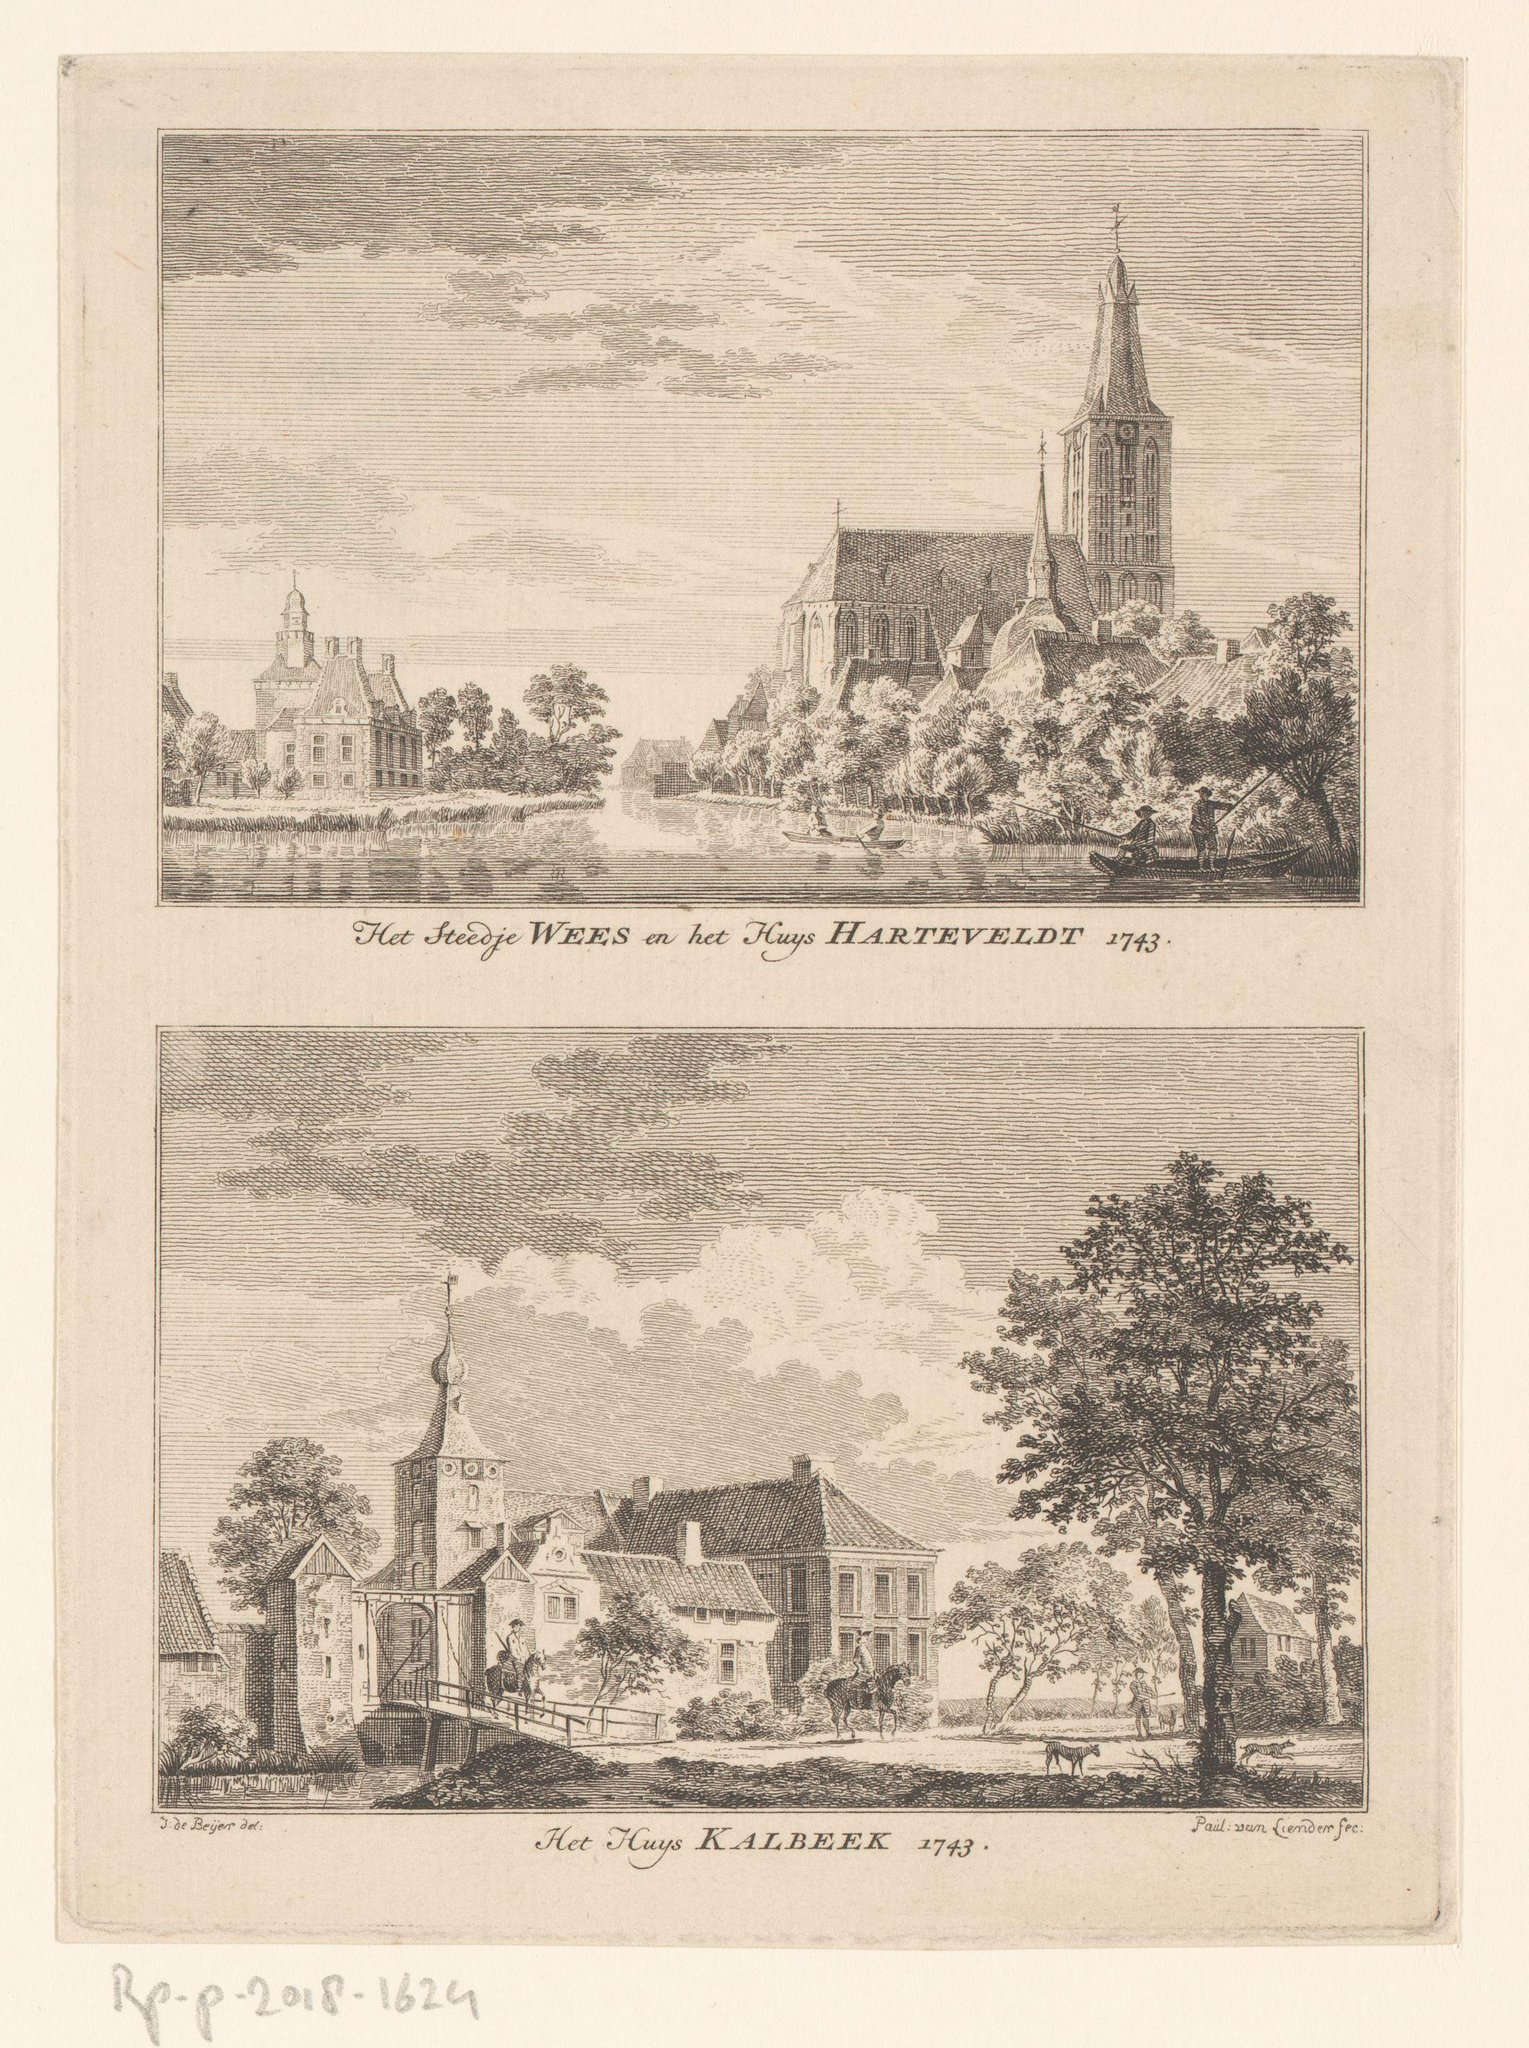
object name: print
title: Het Steedje Wees en het Huys Harteveldt 1743 / Het Huys Kalbeek 1743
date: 1743-1792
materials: paper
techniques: etching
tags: city-view in general; 'veduta', landscapes with waters, waterscapes, seascapes (in the temperate zone), rural housing, e.g. country-house, villa, cottage, church (exterior)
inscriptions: collector's mark: Lugt 2228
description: Prent ook gebruikt in: Beijer, Jan de. Het verheerlykt Kleefschland of Kabinet van Kleefsche oudheden en gezigten. Amsterdam: Jan de Groot et al., 1792.